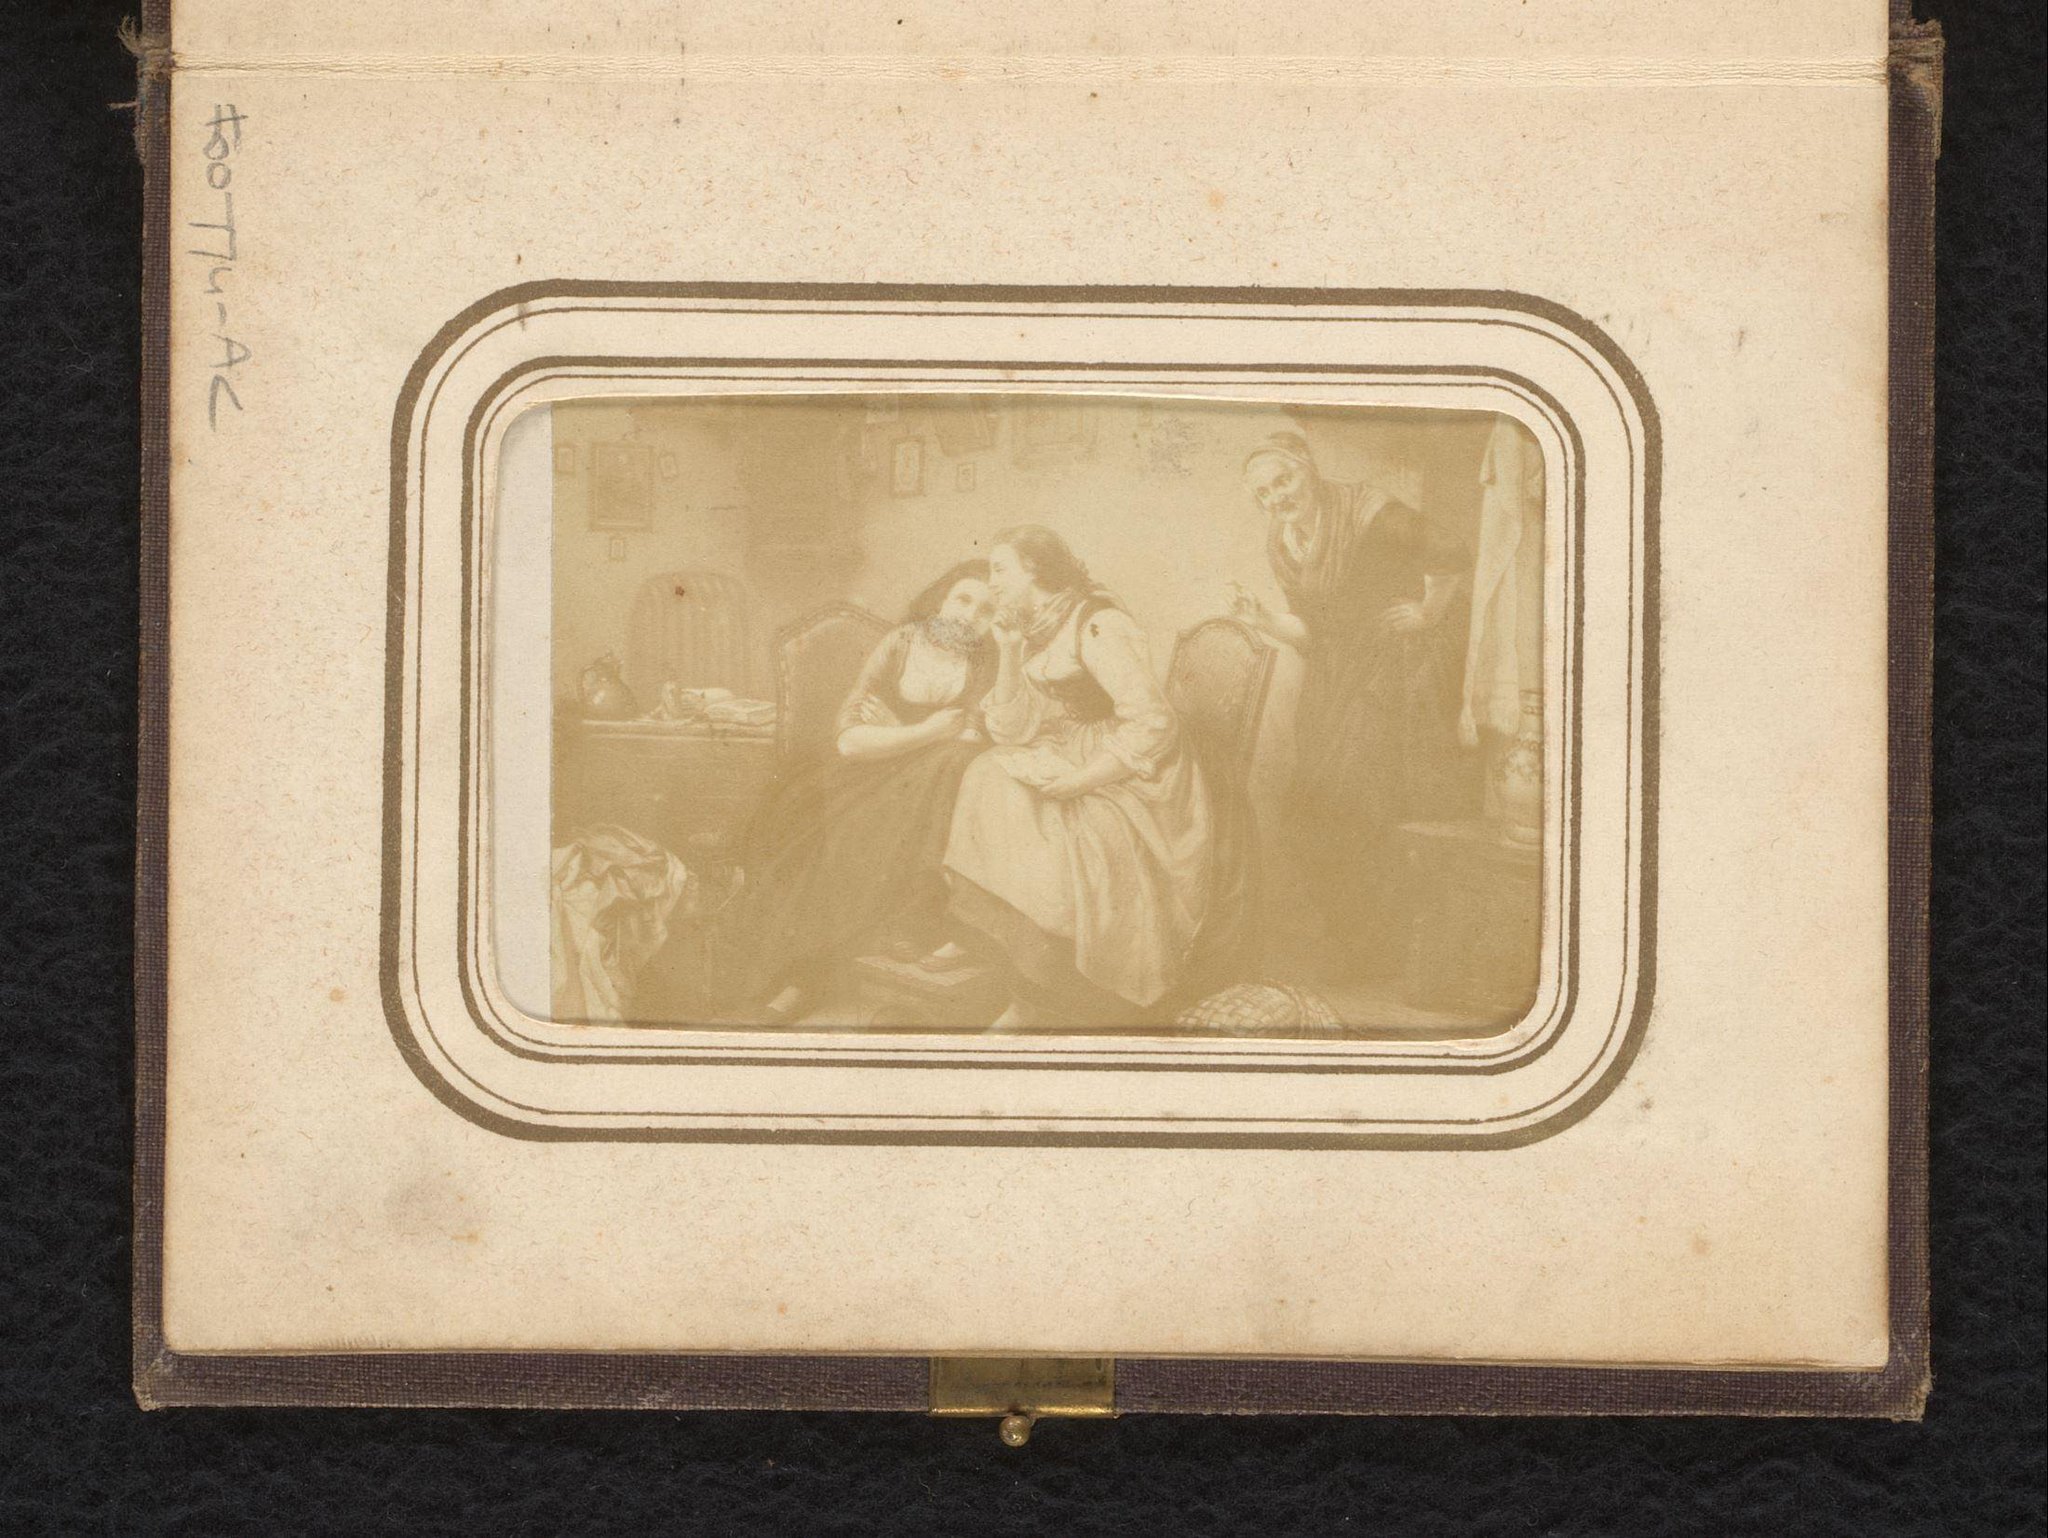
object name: reproduction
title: Fotoreproductie van een schilderij van roddelende vrouwen in een keuken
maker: Anonymous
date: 1850-1900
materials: cardboard, photographic support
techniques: albumen print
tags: kitchen, visiting; receiving guests; elegant company, adult woman (+ three persons)